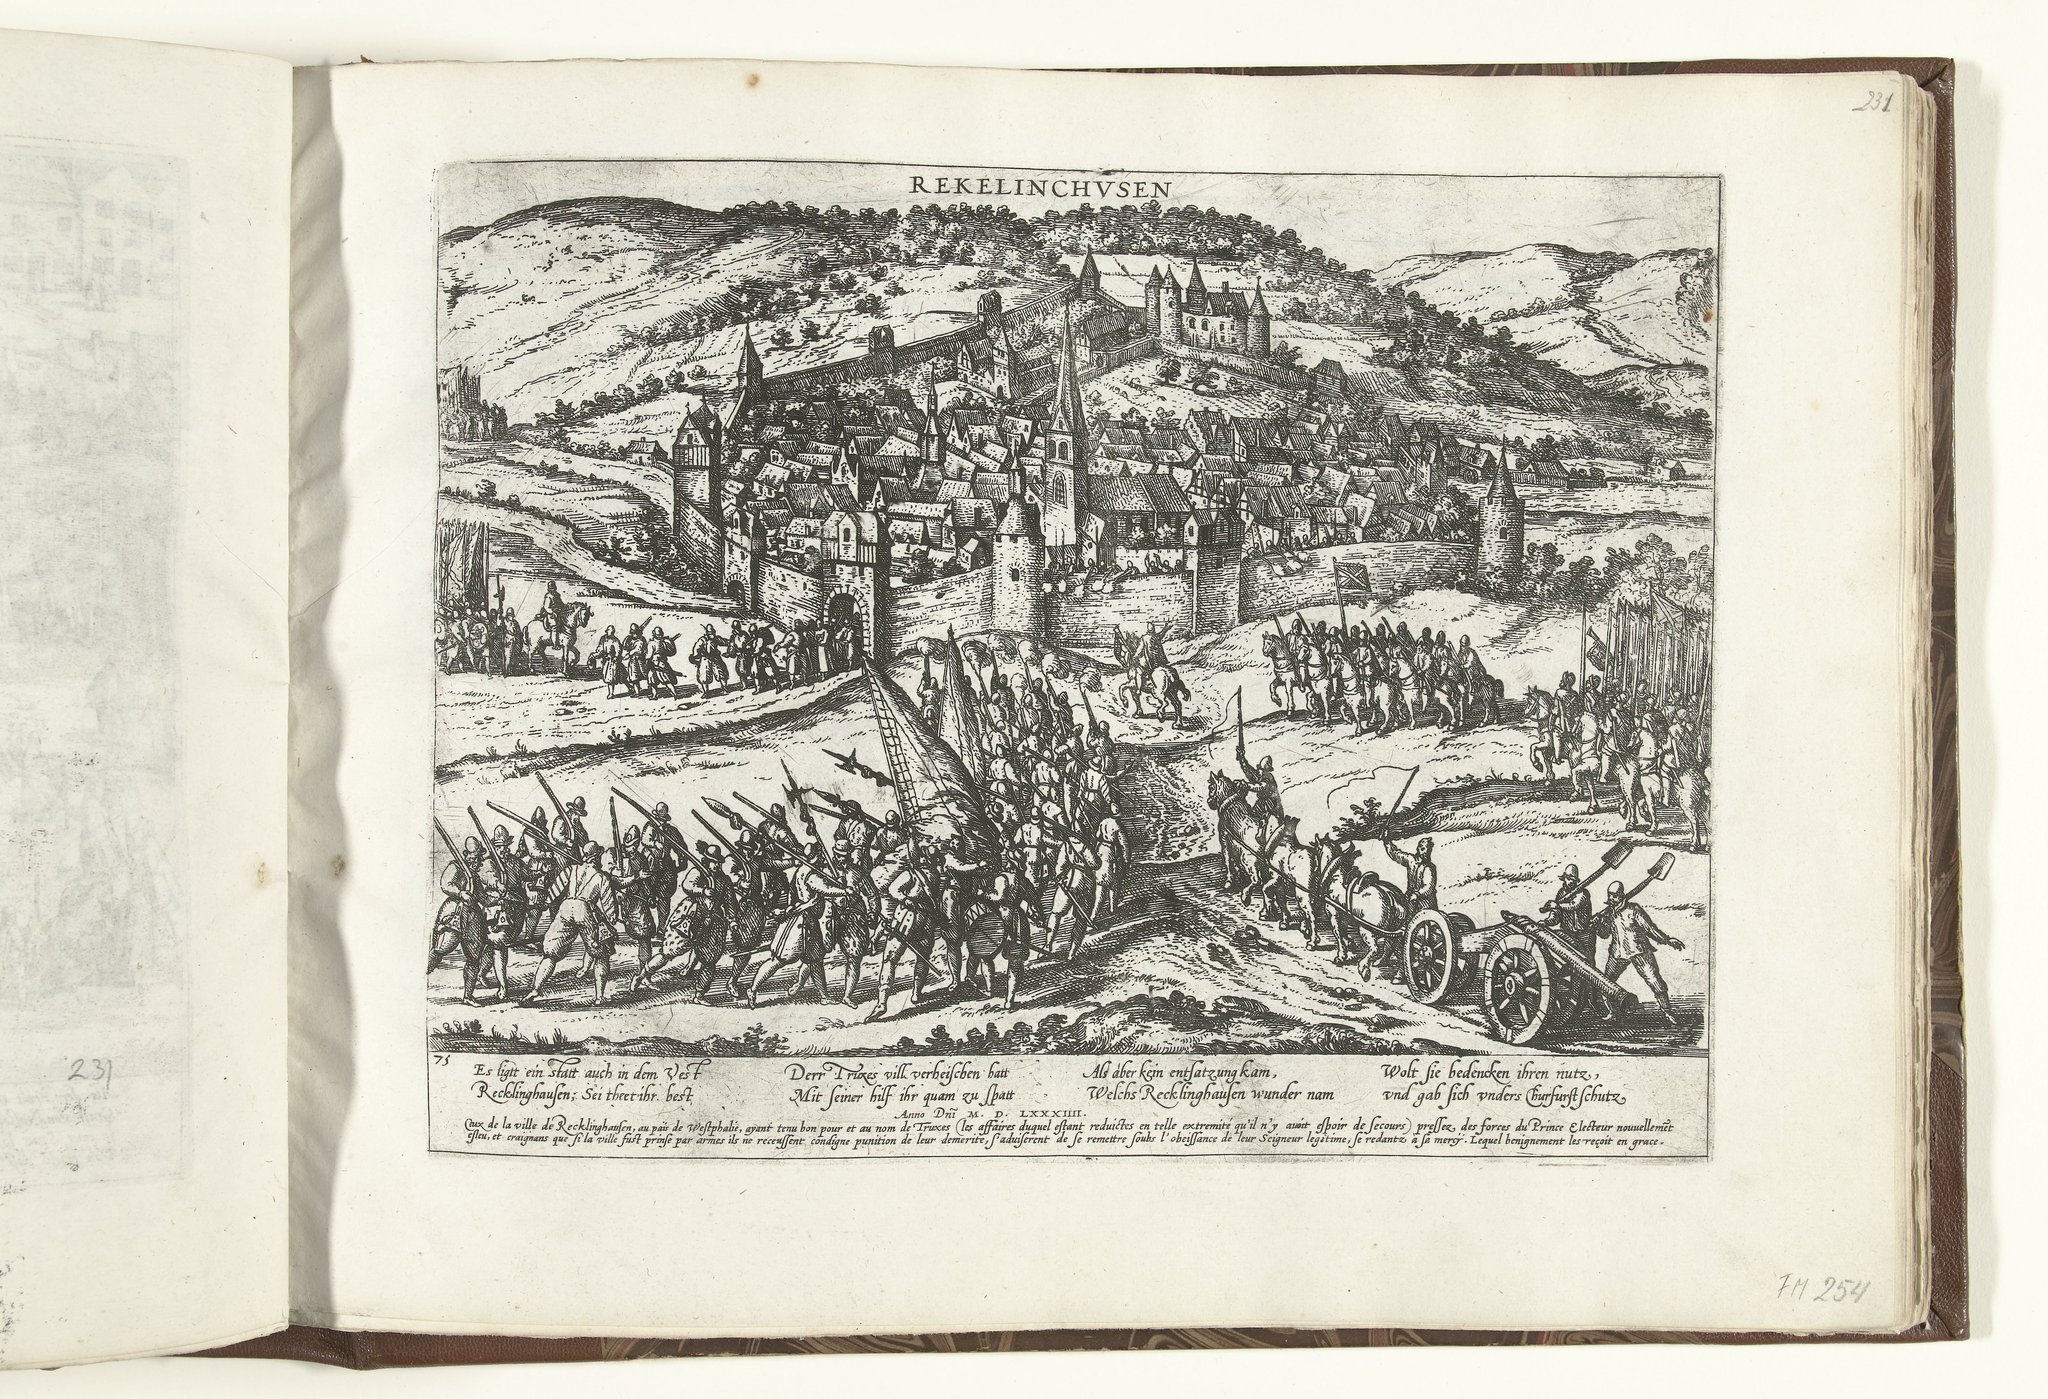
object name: print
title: Serie 9: Nederlandse en Duitse Gebeurtenissen, 1583-1587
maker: frans hogenberg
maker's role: print maker, publisher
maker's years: 1538-1590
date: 1584-1586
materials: paper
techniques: etching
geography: cologne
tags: capture of city (after the siege)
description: Recklinghausen valt Truchsess af, mei 1584, Episode uit de Keulse Oorlog. Met onderschrift van 8 regels in het Duits en 2 regels in het Frans. Genummerd: 75.